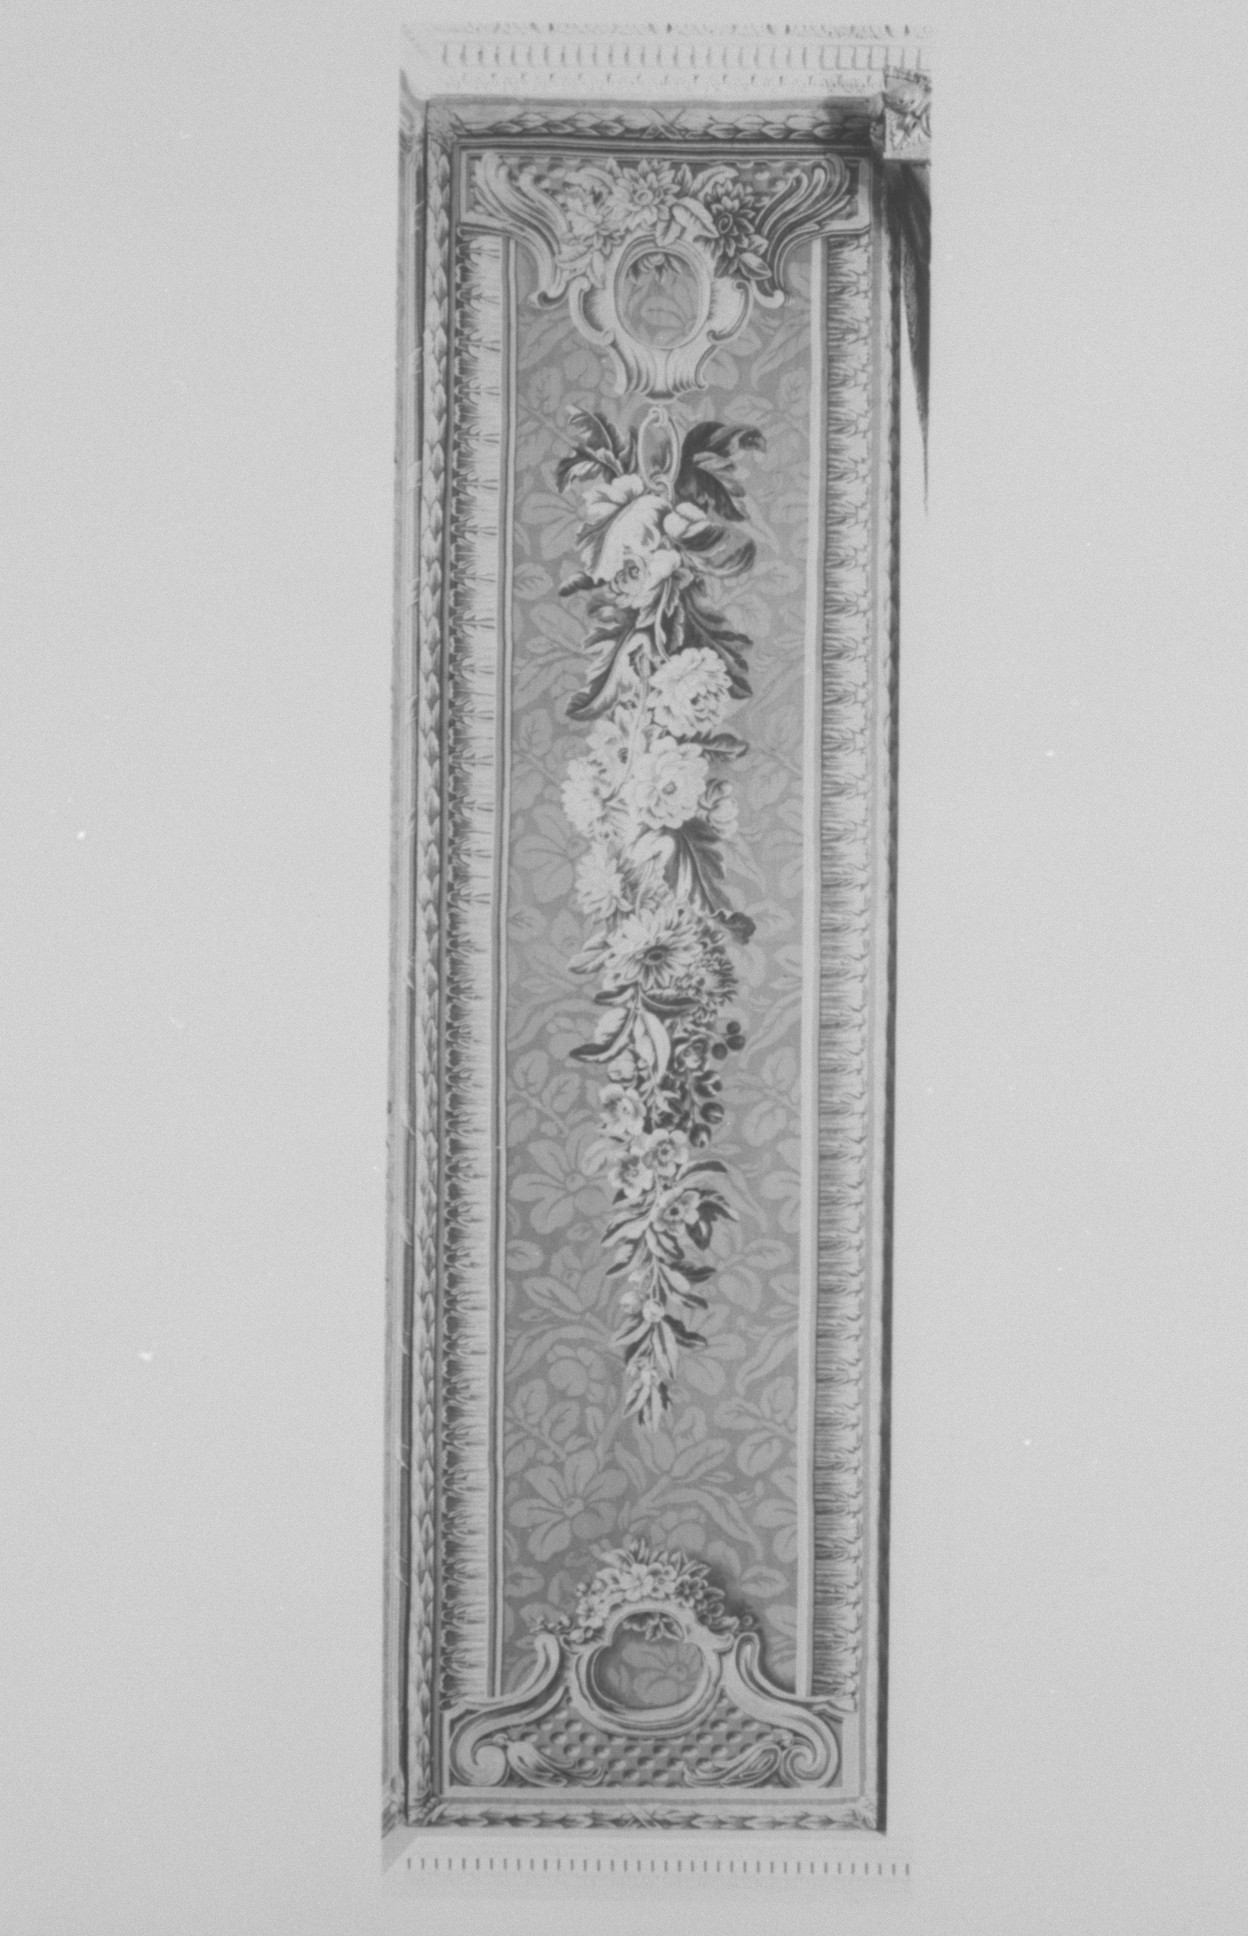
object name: tapestry panel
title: Vertical panels with garland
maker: jacques germain soufflot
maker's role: designer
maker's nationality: french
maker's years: 1713-1780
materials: silk, wool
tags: flowers